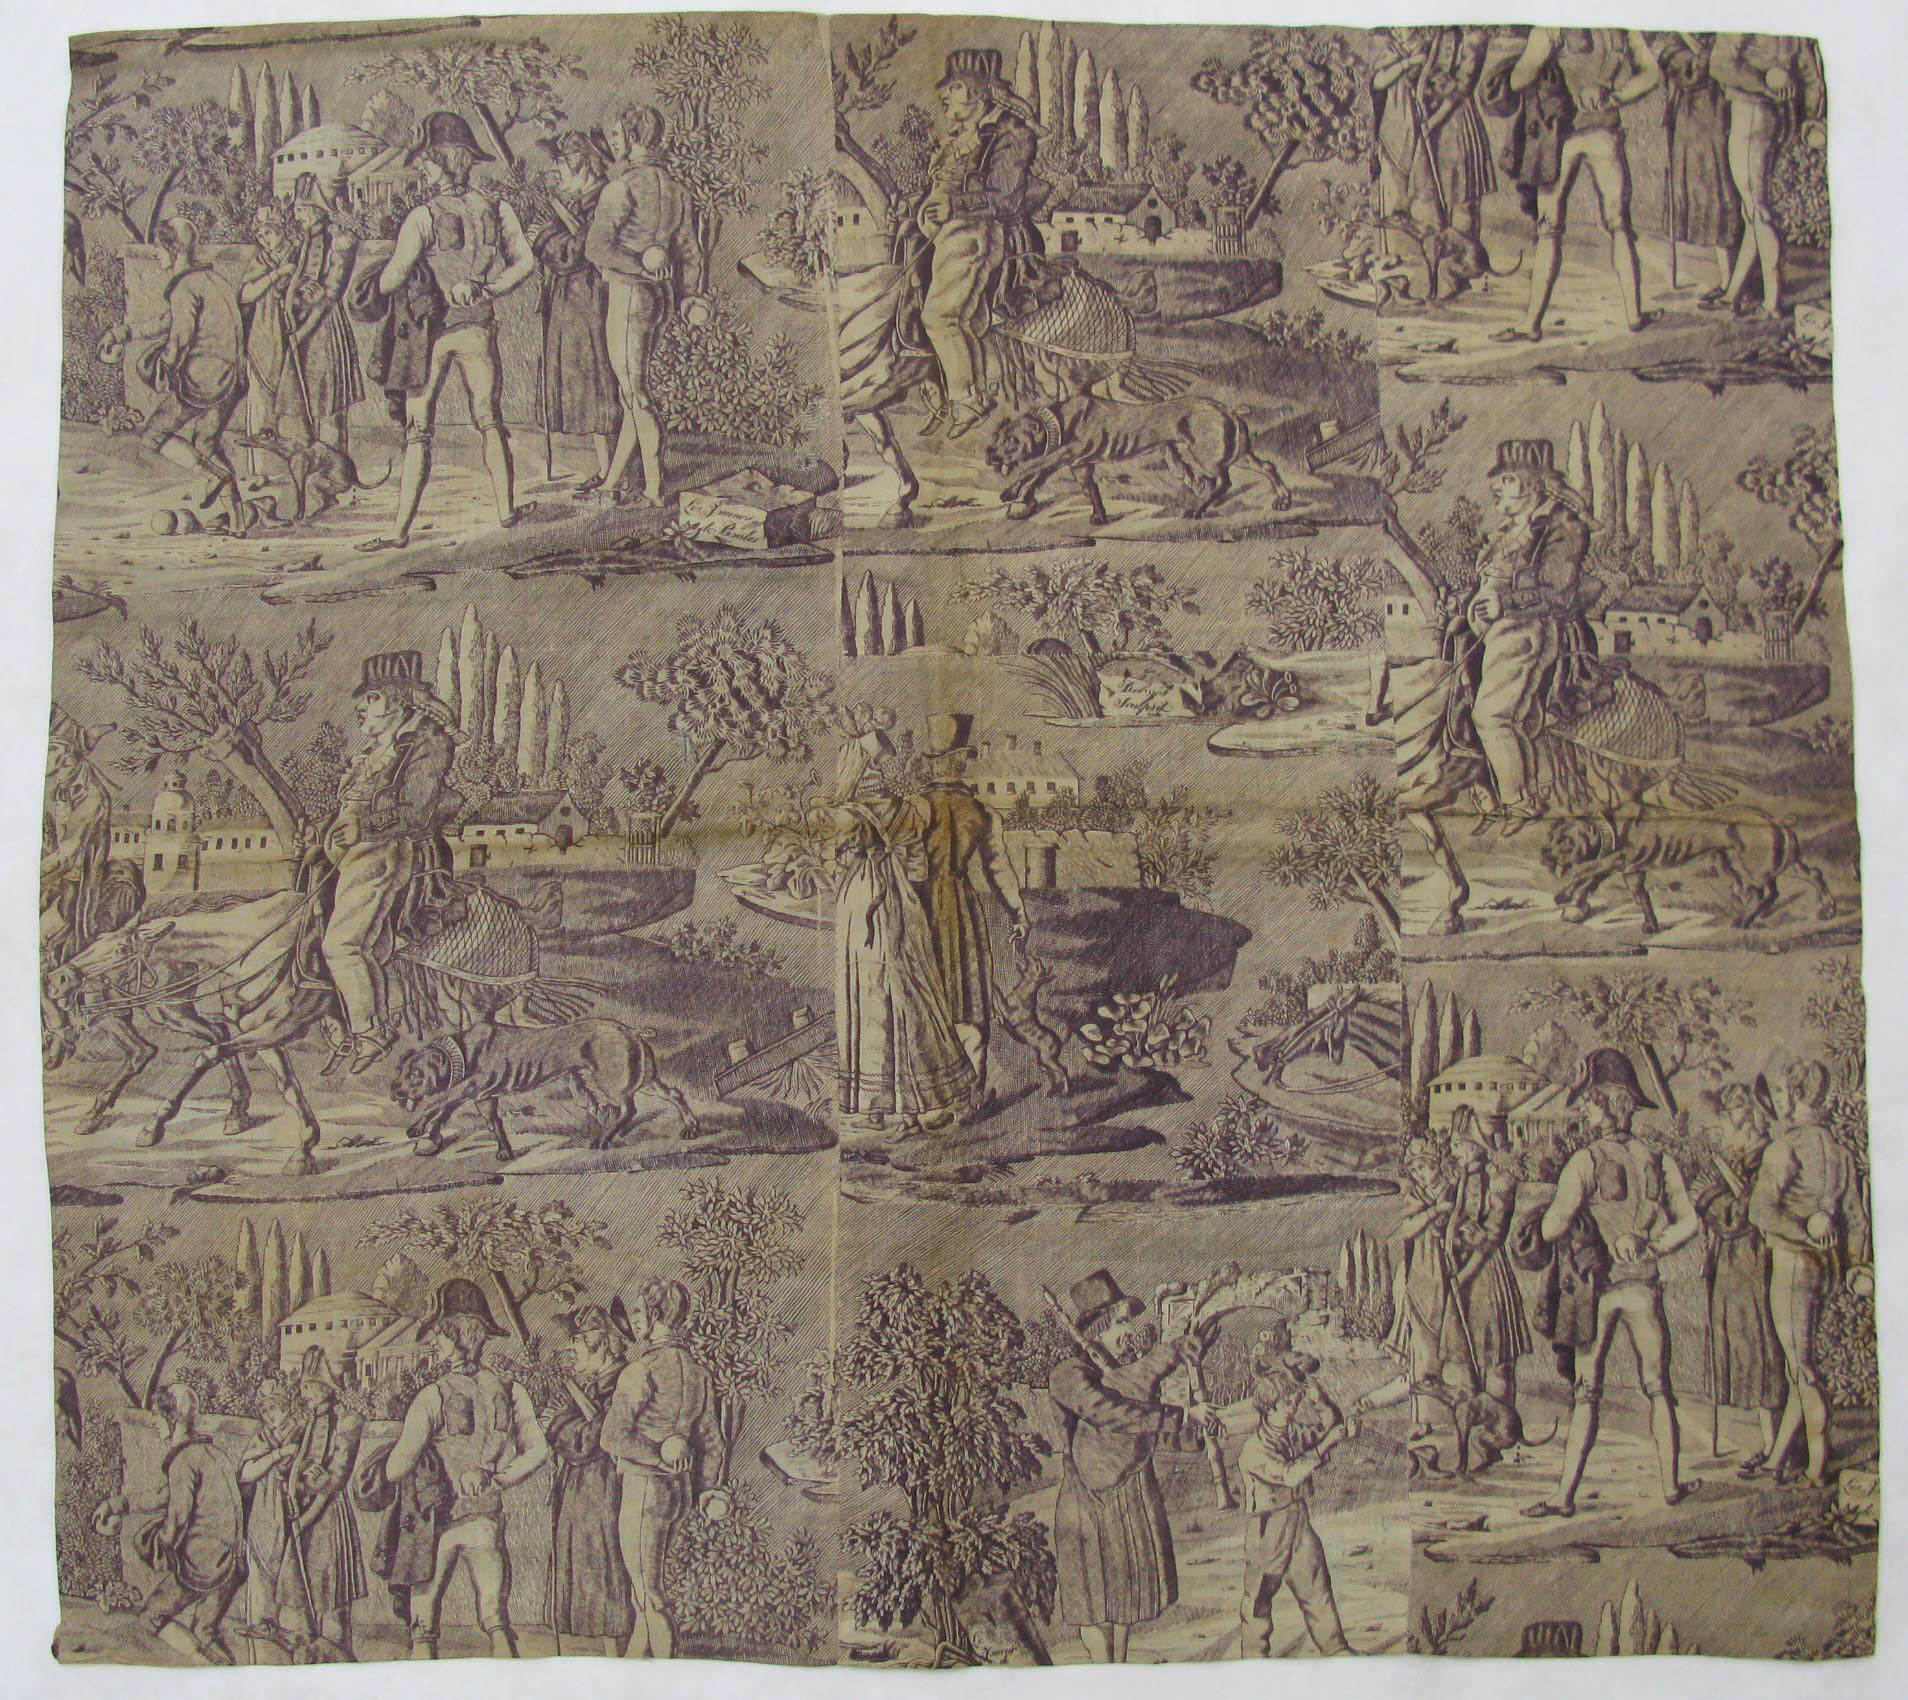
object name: length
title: Afternoon scenes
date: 1820-1829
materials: cotton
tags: men,women,dogs,horses,trees